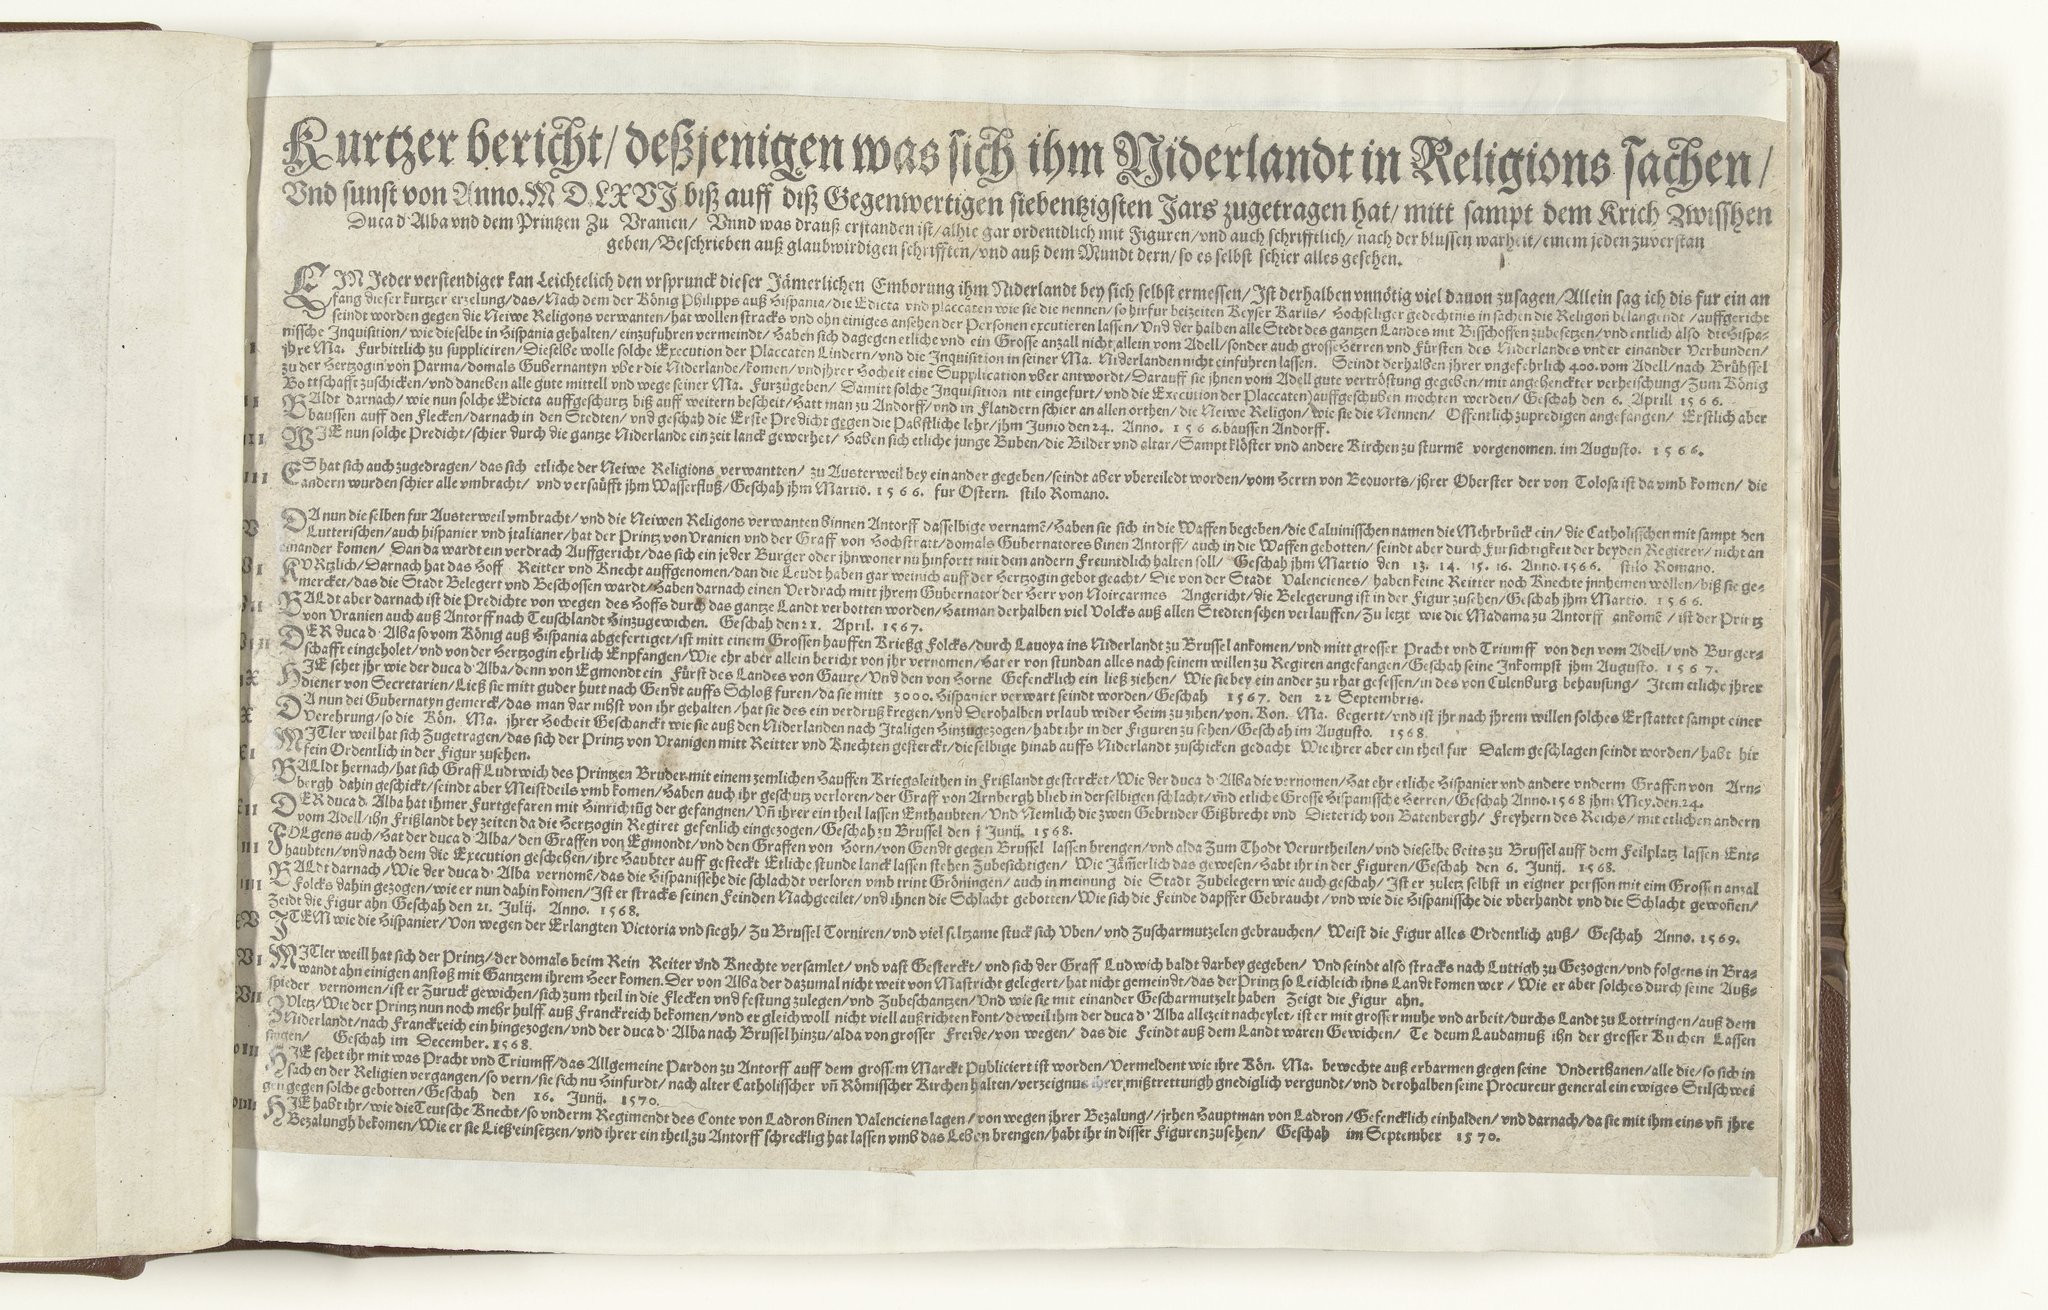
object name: titelblad, titelpagina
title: Titelblad voor de reeks prenten over de gebeurtenissen in de Nederlanden 1566-1570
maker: frans hogenberg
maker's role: print maker, publisher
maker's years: 1538-1590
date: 1570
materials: paper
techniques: letterpress printing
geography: cologne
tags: tachtigjarige oorlog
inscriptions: date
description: Titelblad met overzicht van de onderwerpen van deze reeks prenten over de gebeurtenissen in de Nederlanden 1566-1570. Tekst in boekdruk in het Duits.